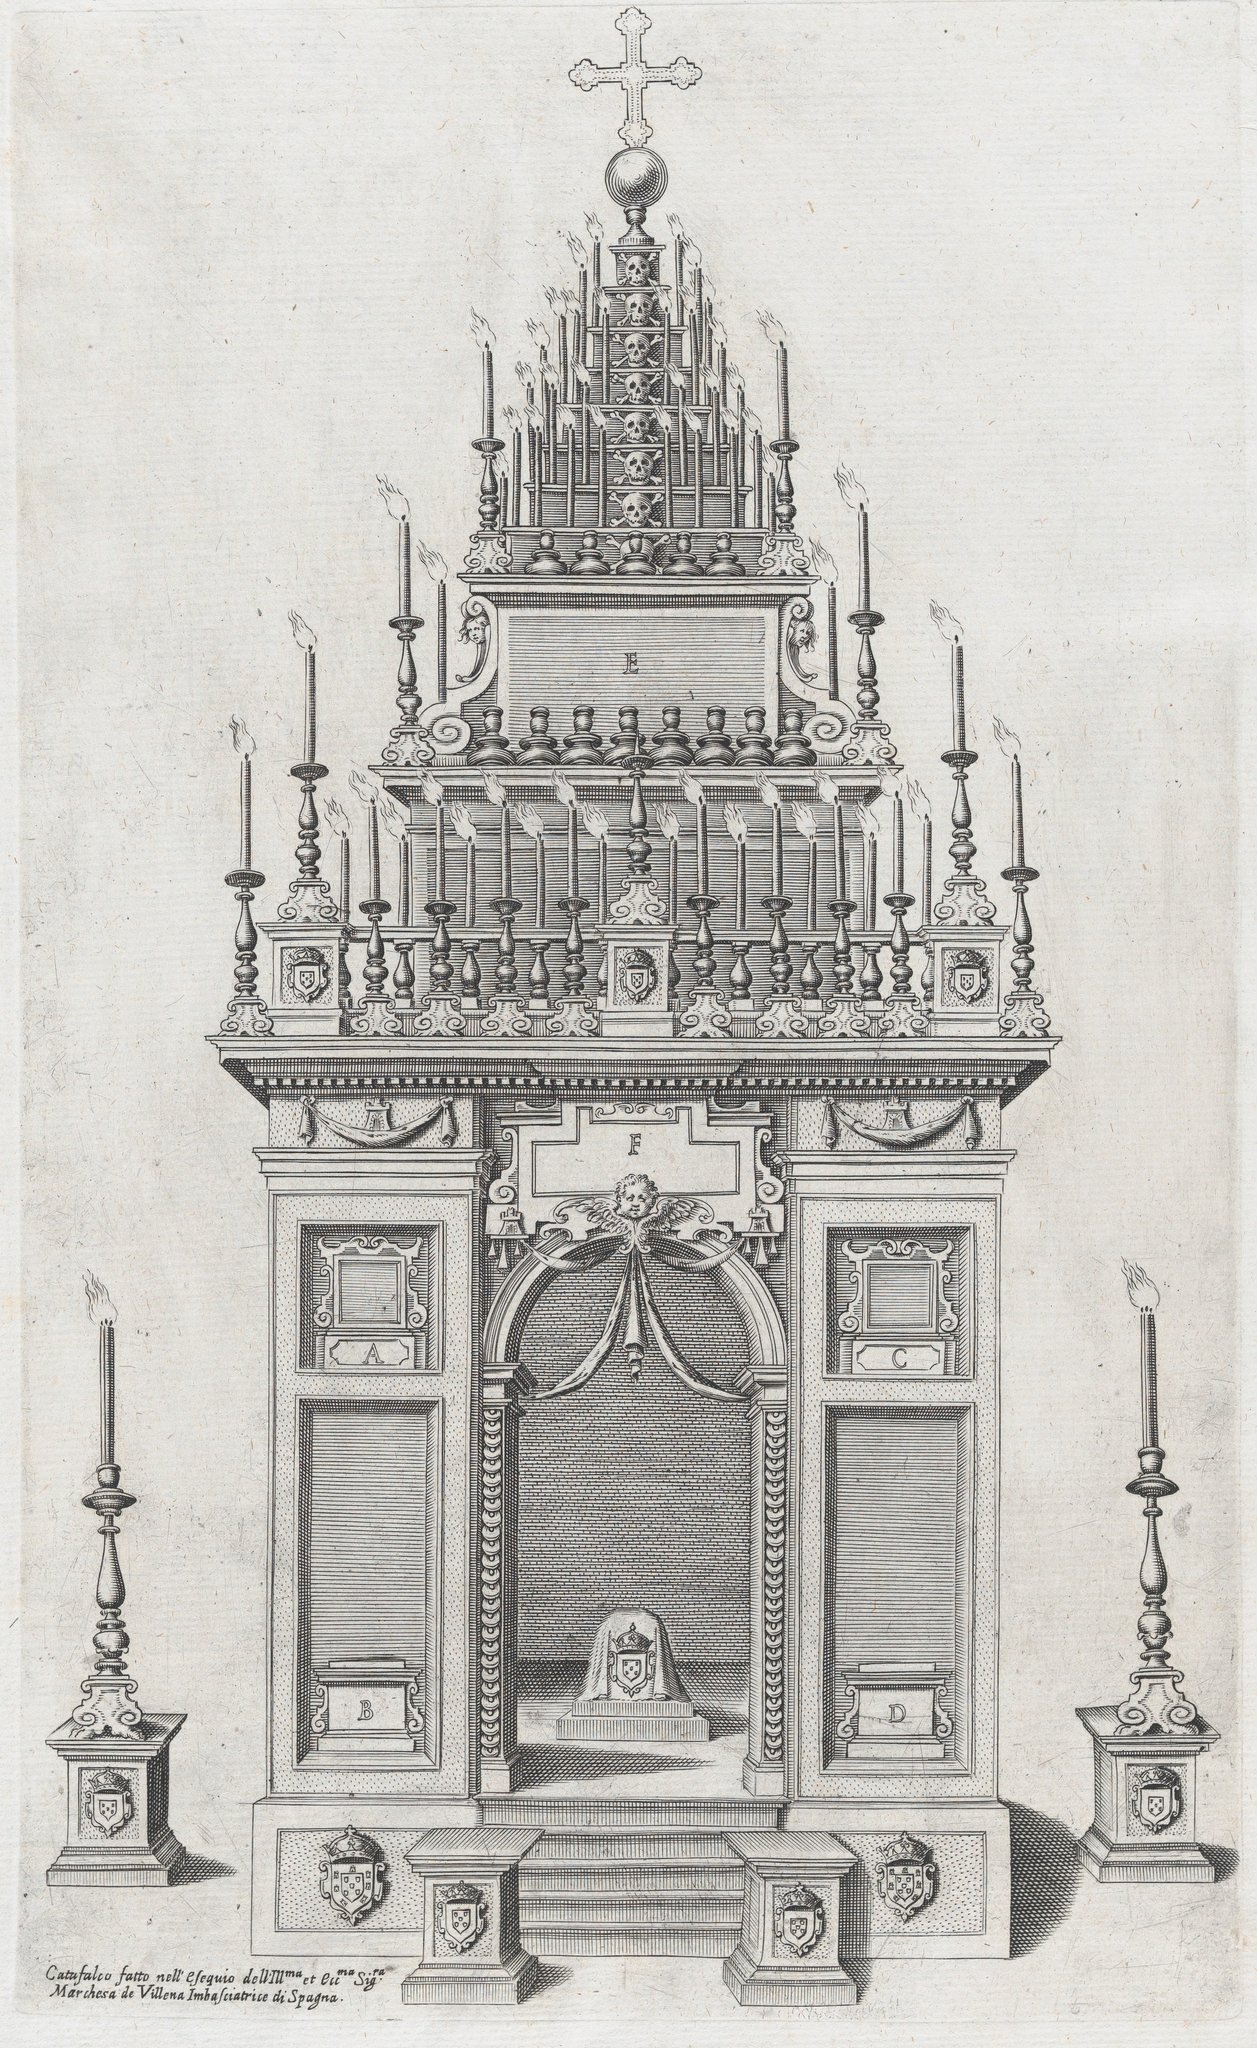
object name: print, fete, ornament architecture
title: Design of the catafalque for the exequies of the Marchesa di Villena in San Giacomo degli Spagnoli, Rome; from 'Libro De Catafalchi, Tabernacoli, con varij designi di Porte fenestre et altri ornamenti di Architettura'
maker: Anonymous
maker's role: artist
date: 1604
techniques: engraving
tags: tabernacles